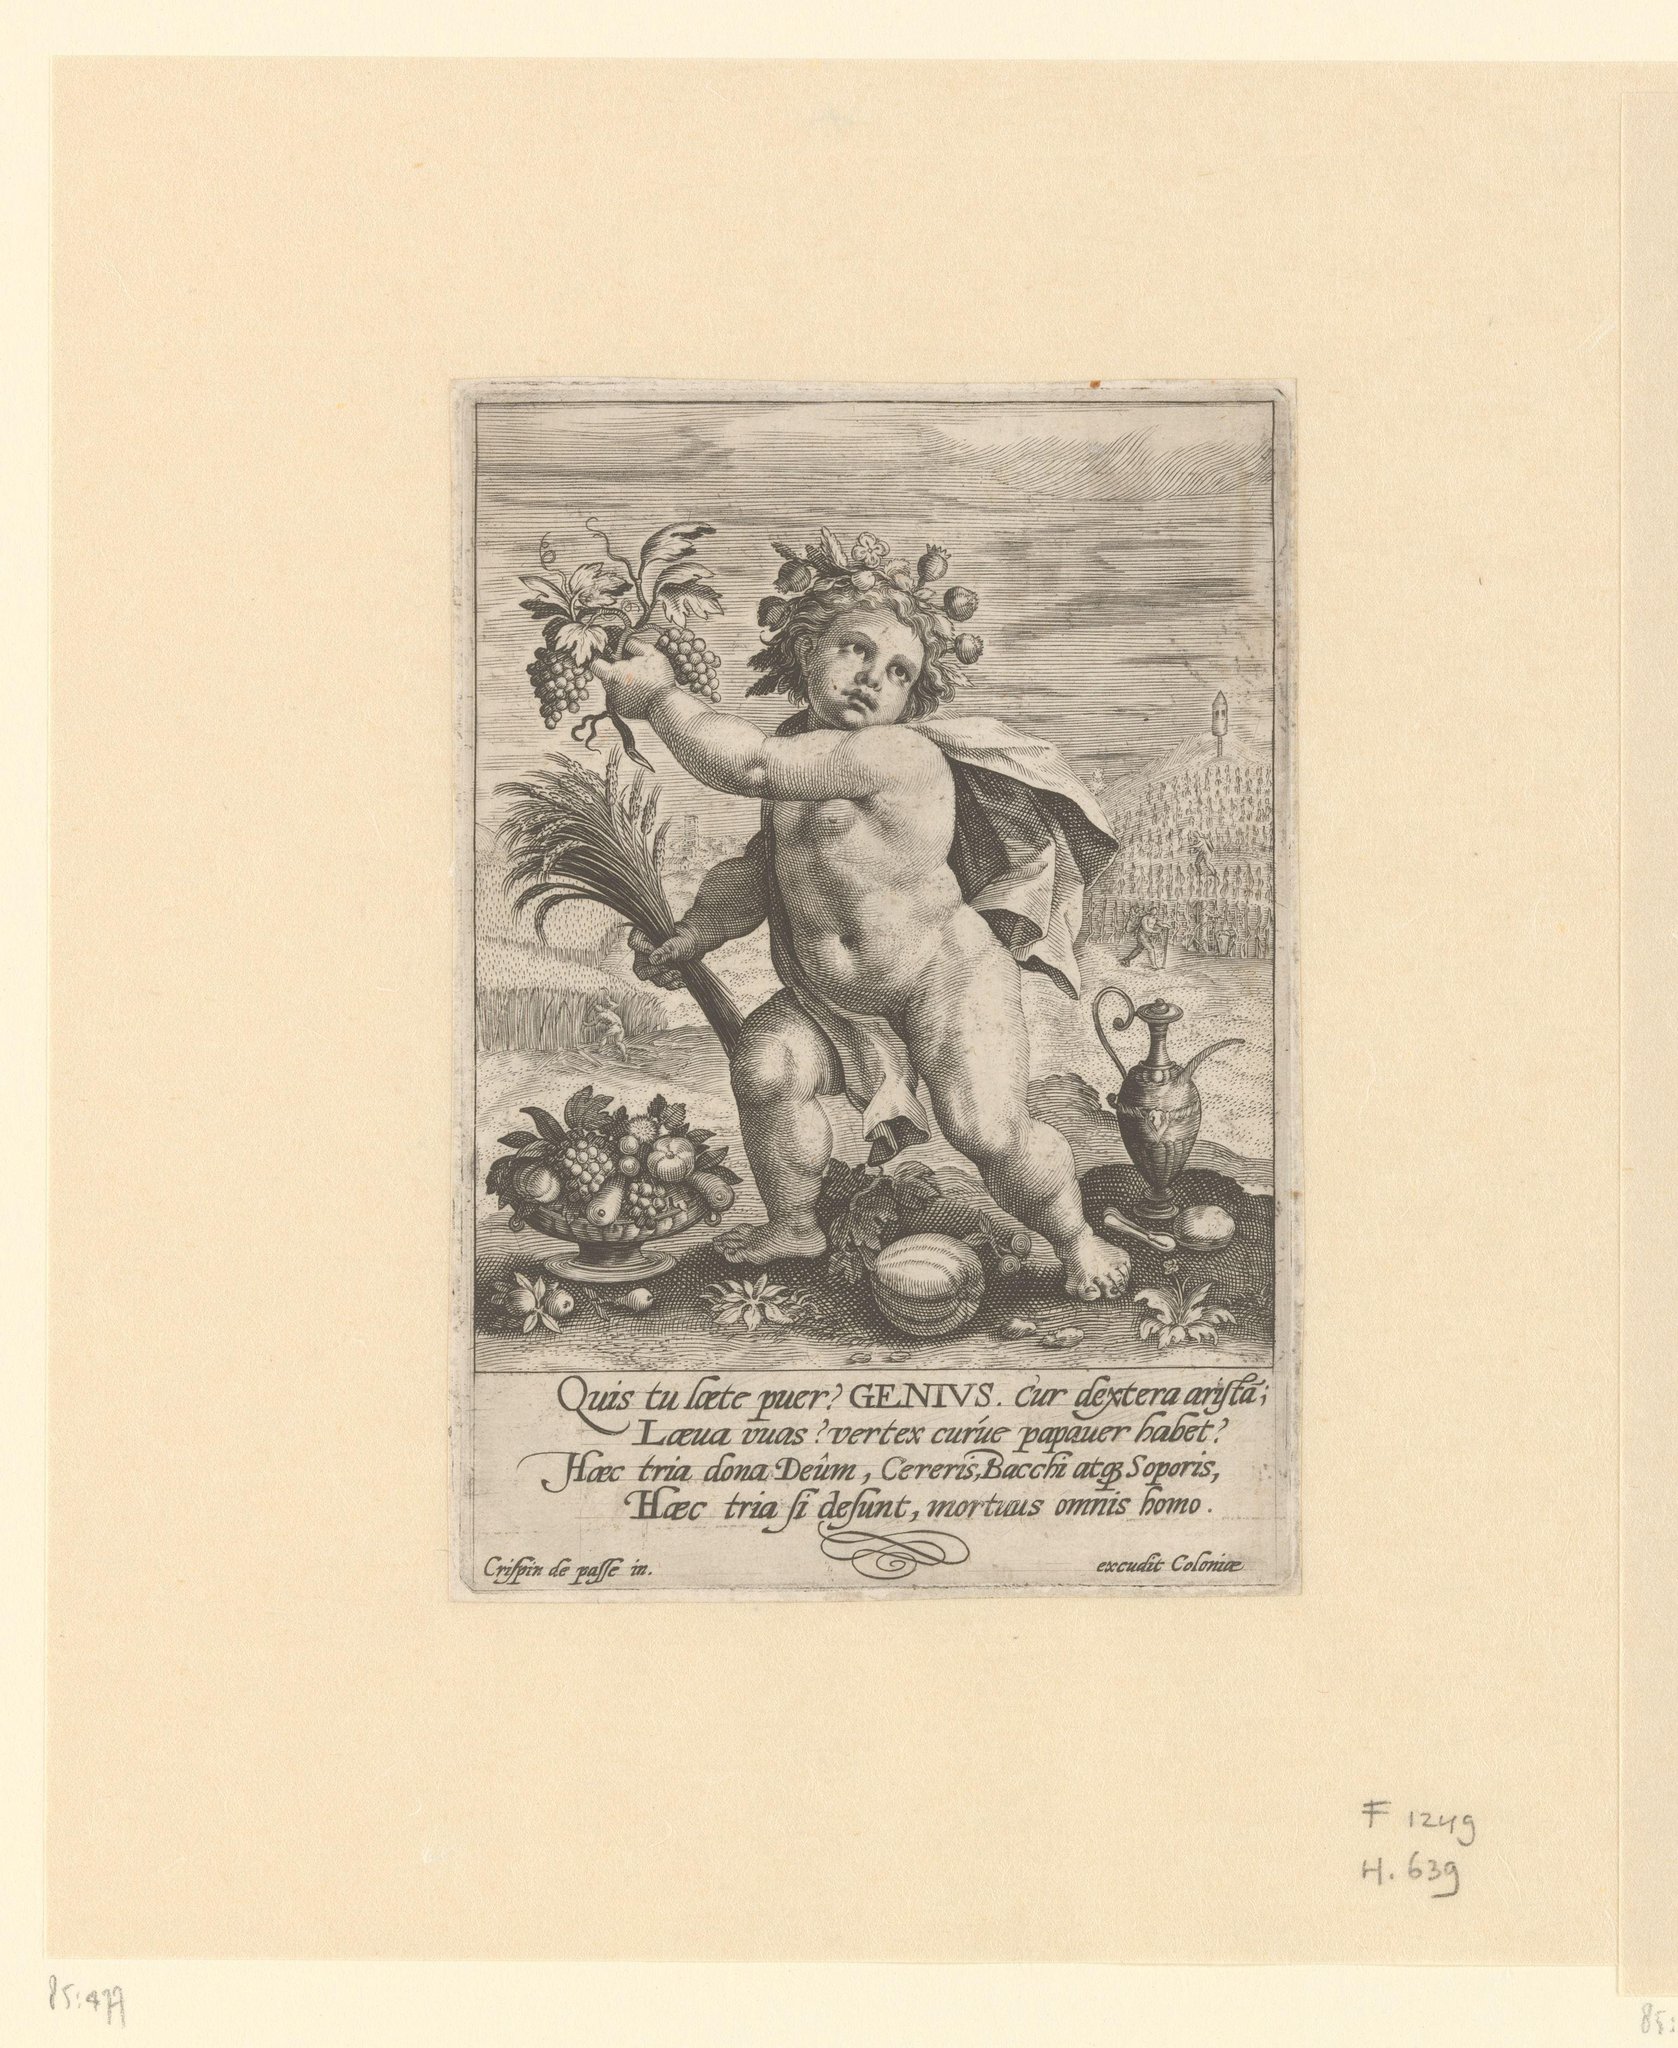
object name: print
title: De essentie van het menselijk bestaan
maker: crispijn van de passe (i)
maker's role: draughtsman, print maker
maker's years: 1564-1637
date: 1589-1611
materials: paper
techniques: engraving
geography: cologne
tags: human life; 'vita humana', 'vita inquieta', 'vita e l'animo' (ripa), vineyard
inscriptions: number: ‘i’, collector's mark: Lugt 2228, collector's mark: Lugt 2760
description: Genius, een putto met een papaverkroon en in zijn handen de vruchten van het land (een tros druiven en een korenbundel) die de basisbehoeftes voedsel, drank en slaap vertegenwoordigen. Dit waren volgens het Latijnse onderschrift van de prent onmisbare giften die de natuur de mens geschonken had om te overleven.